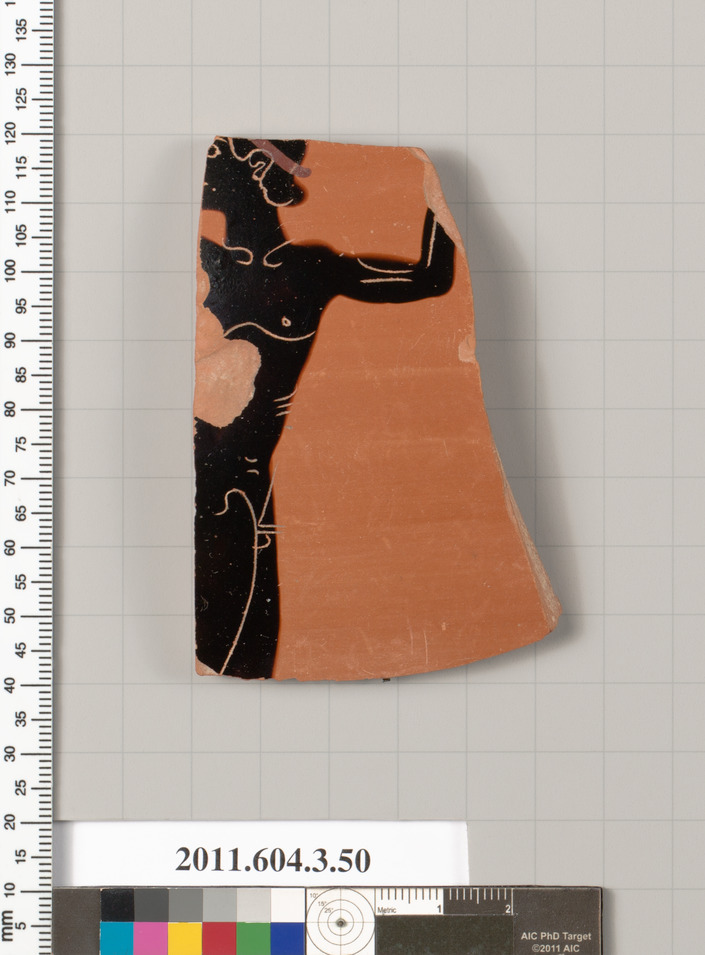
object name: amphora fragment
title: Terracotta fragment of an amphora (jar)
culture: greek, attic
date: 510-500 BCE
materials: terracotta